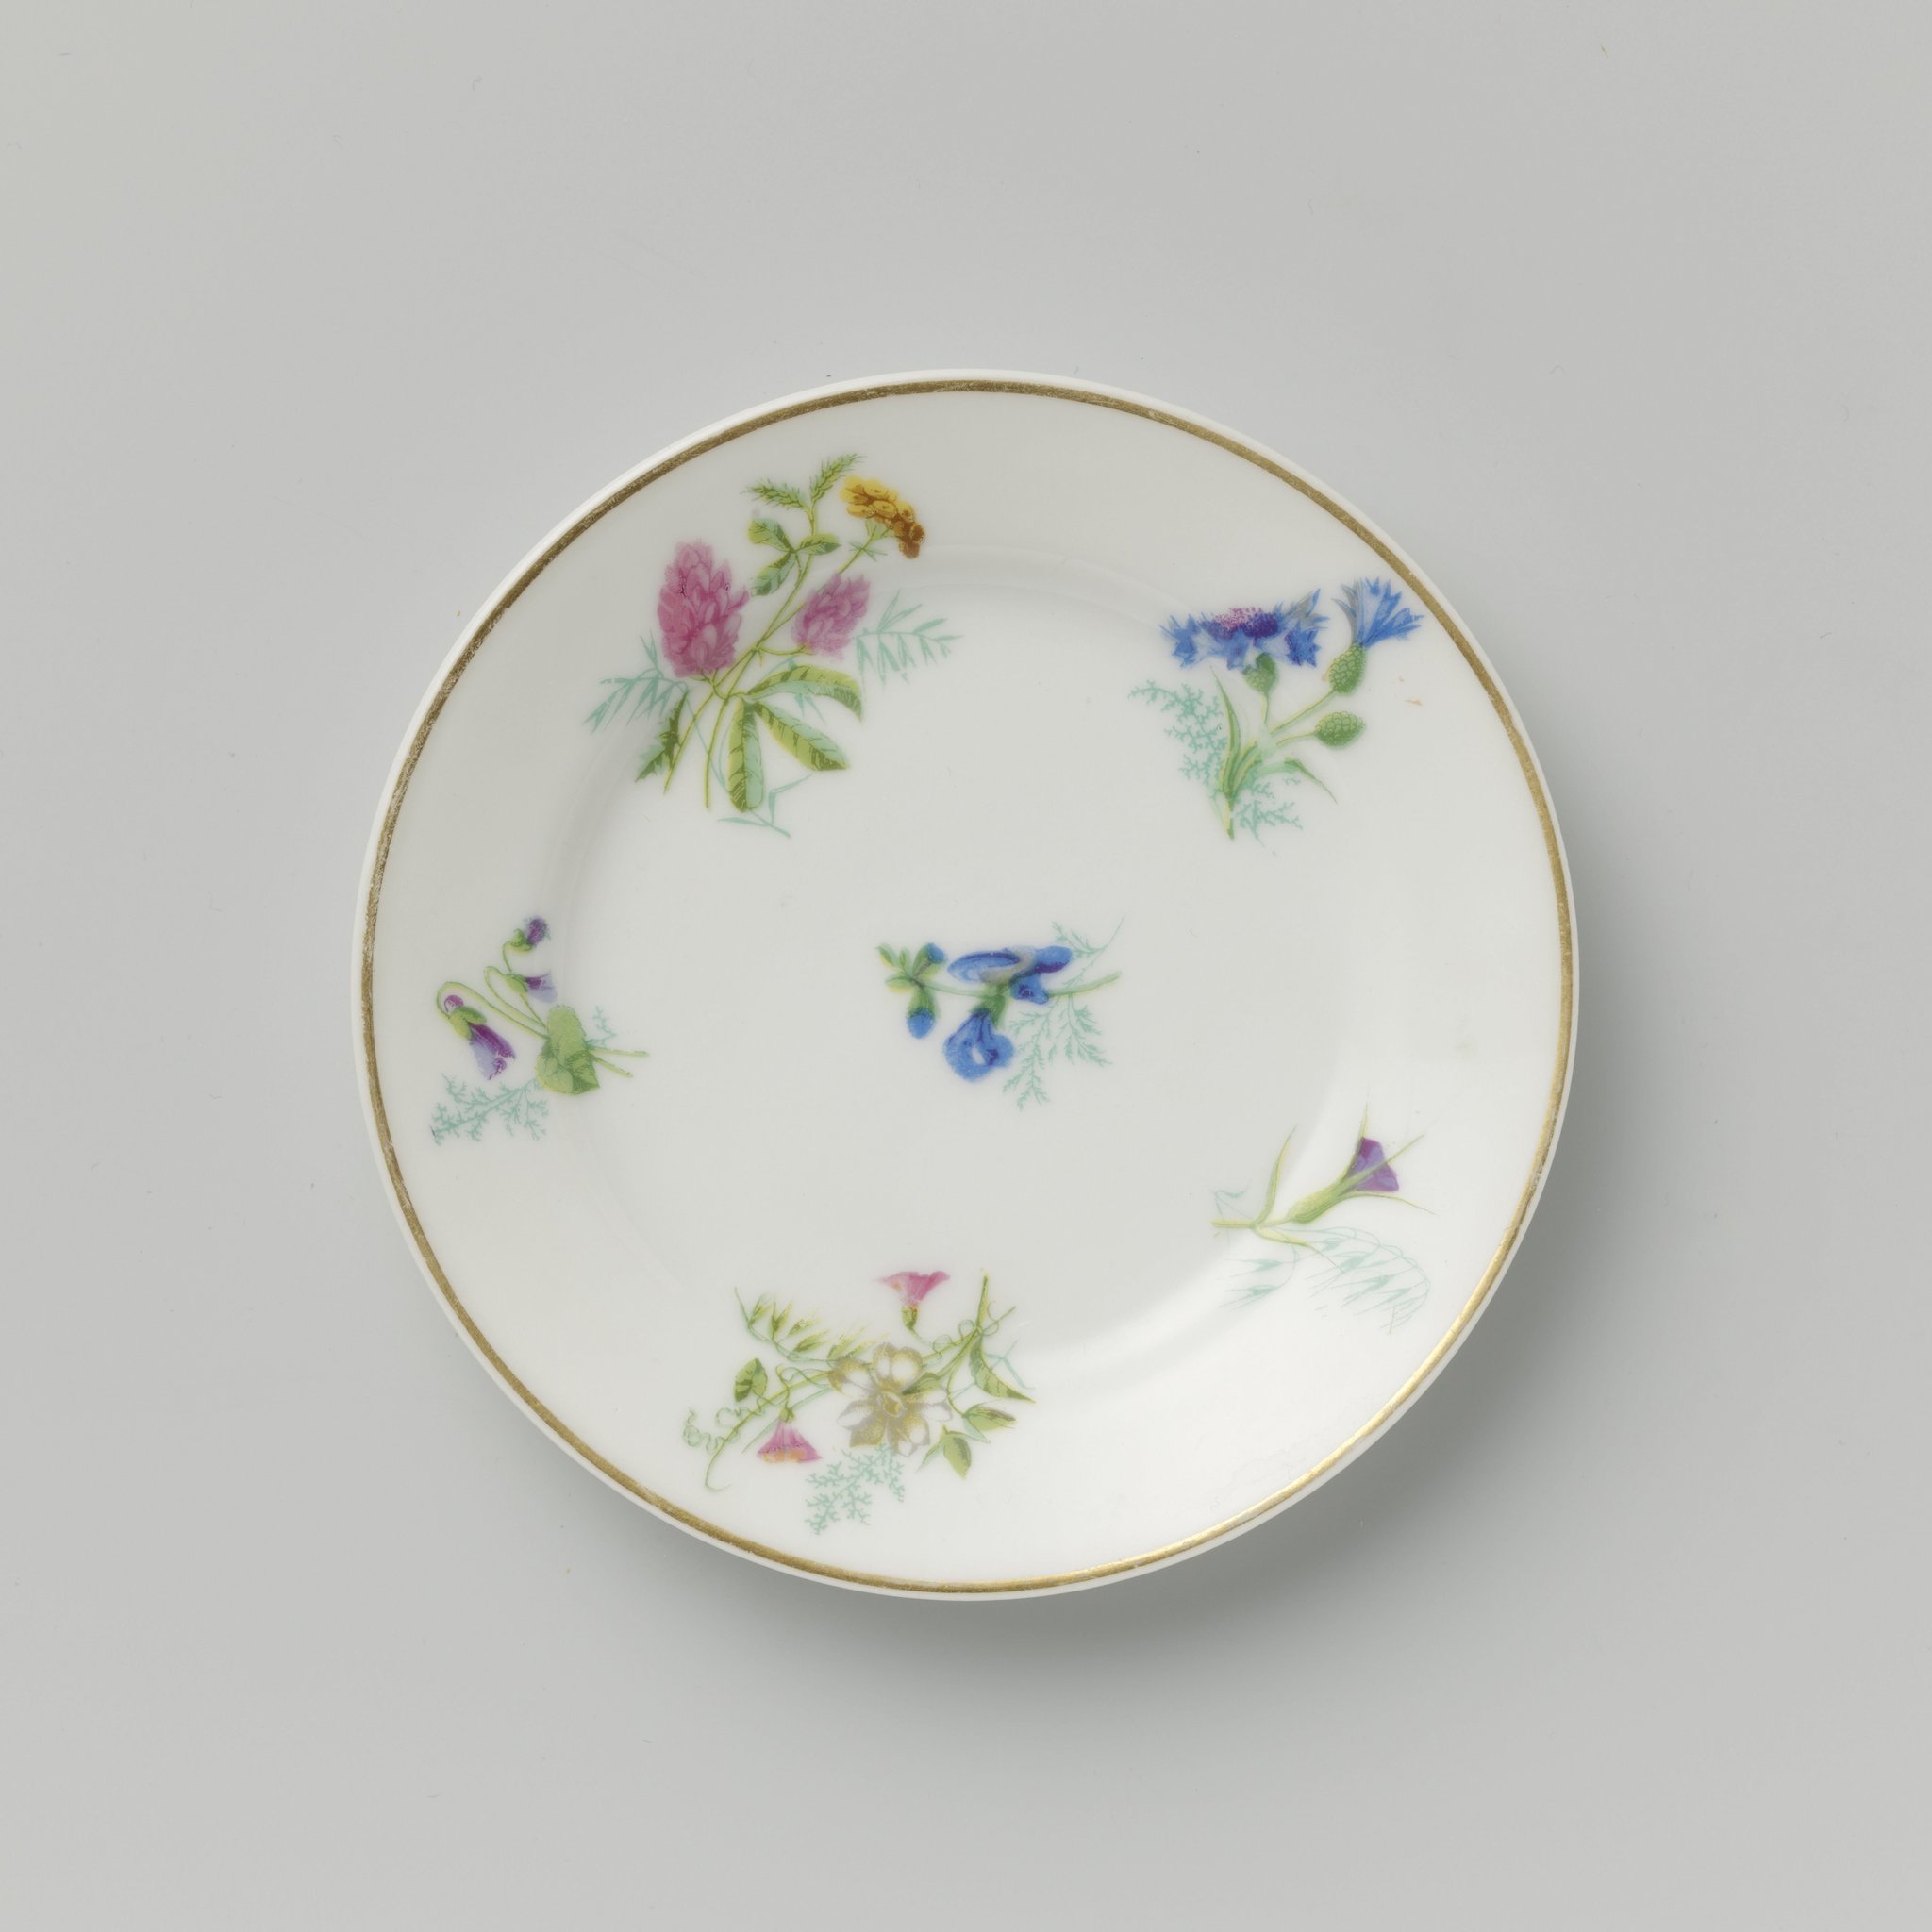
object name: kinderservies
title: Dish with various flower sprays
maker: Anonymous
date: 1850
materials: glaze, gold, paint, porcelain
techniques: firing, forming, gilding, turning, vitrification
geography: france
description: Schotel van porselein, versierd op het glazuur met blauw, rood, roze, groen, geel, paars en goud. Op de voorzijde verschillende bloemtakken en een gouden lijn op de rand.